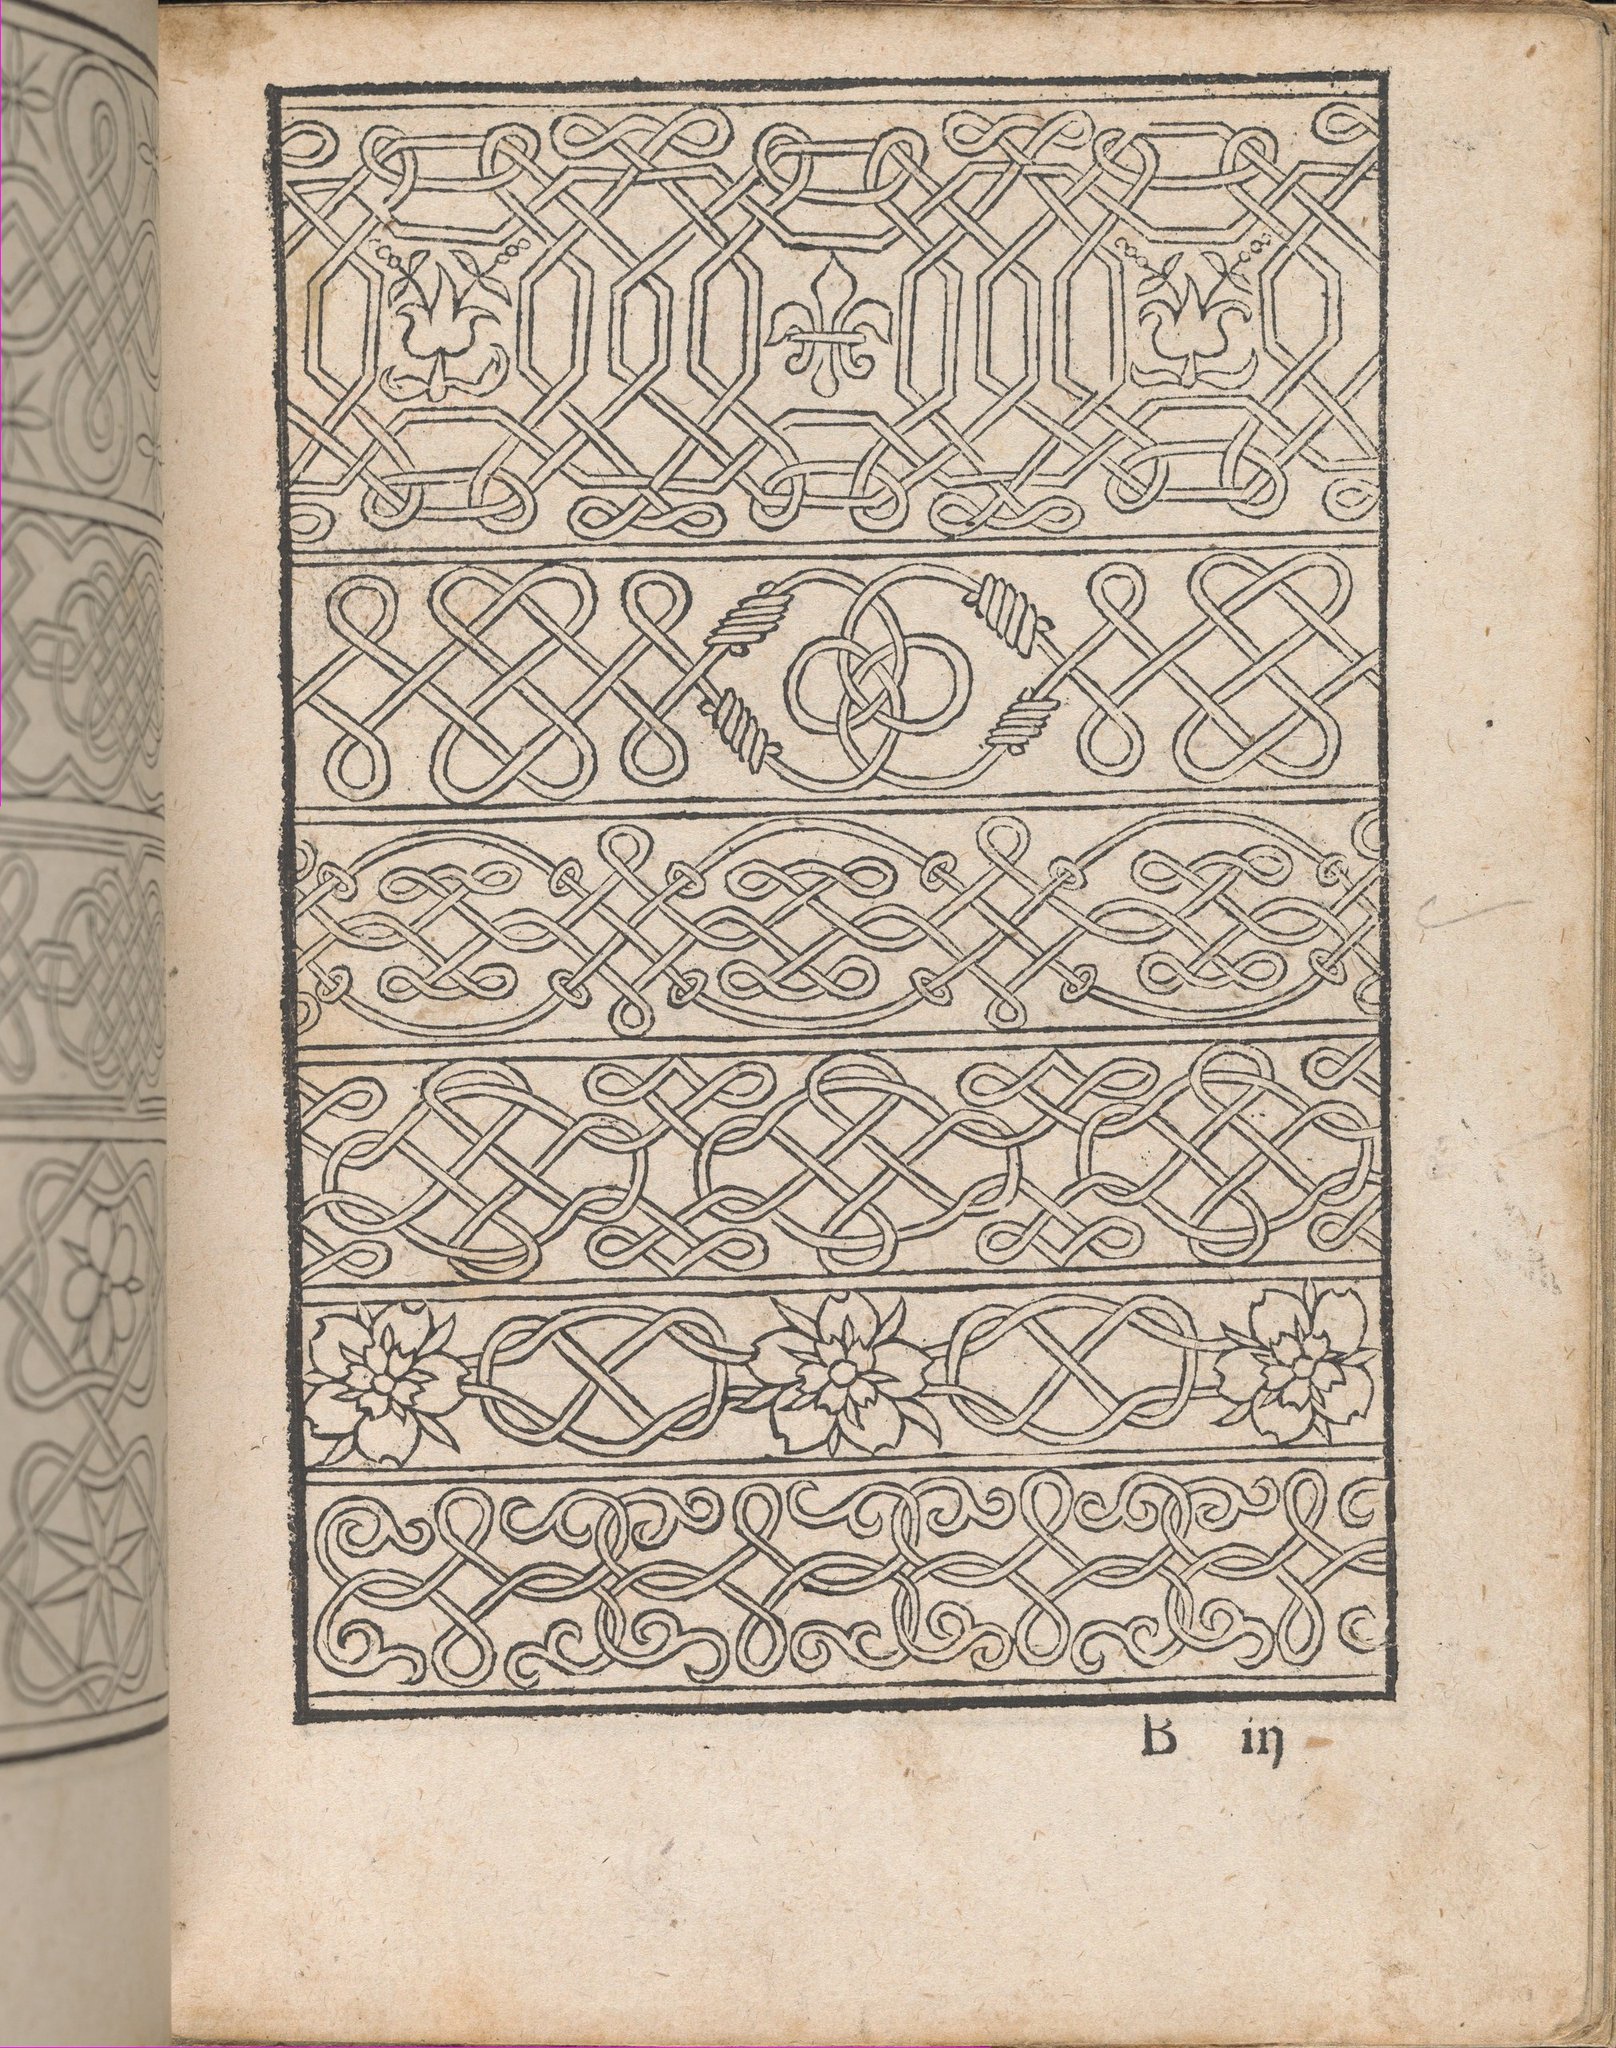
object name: book print ornament architecture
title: New Modelbüch allen Nägerin u. Sydenstickern (Page 7r)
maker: hans hoffman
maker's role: designer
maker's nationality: german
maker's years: 1556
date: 1556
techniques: woodcut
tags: ornament